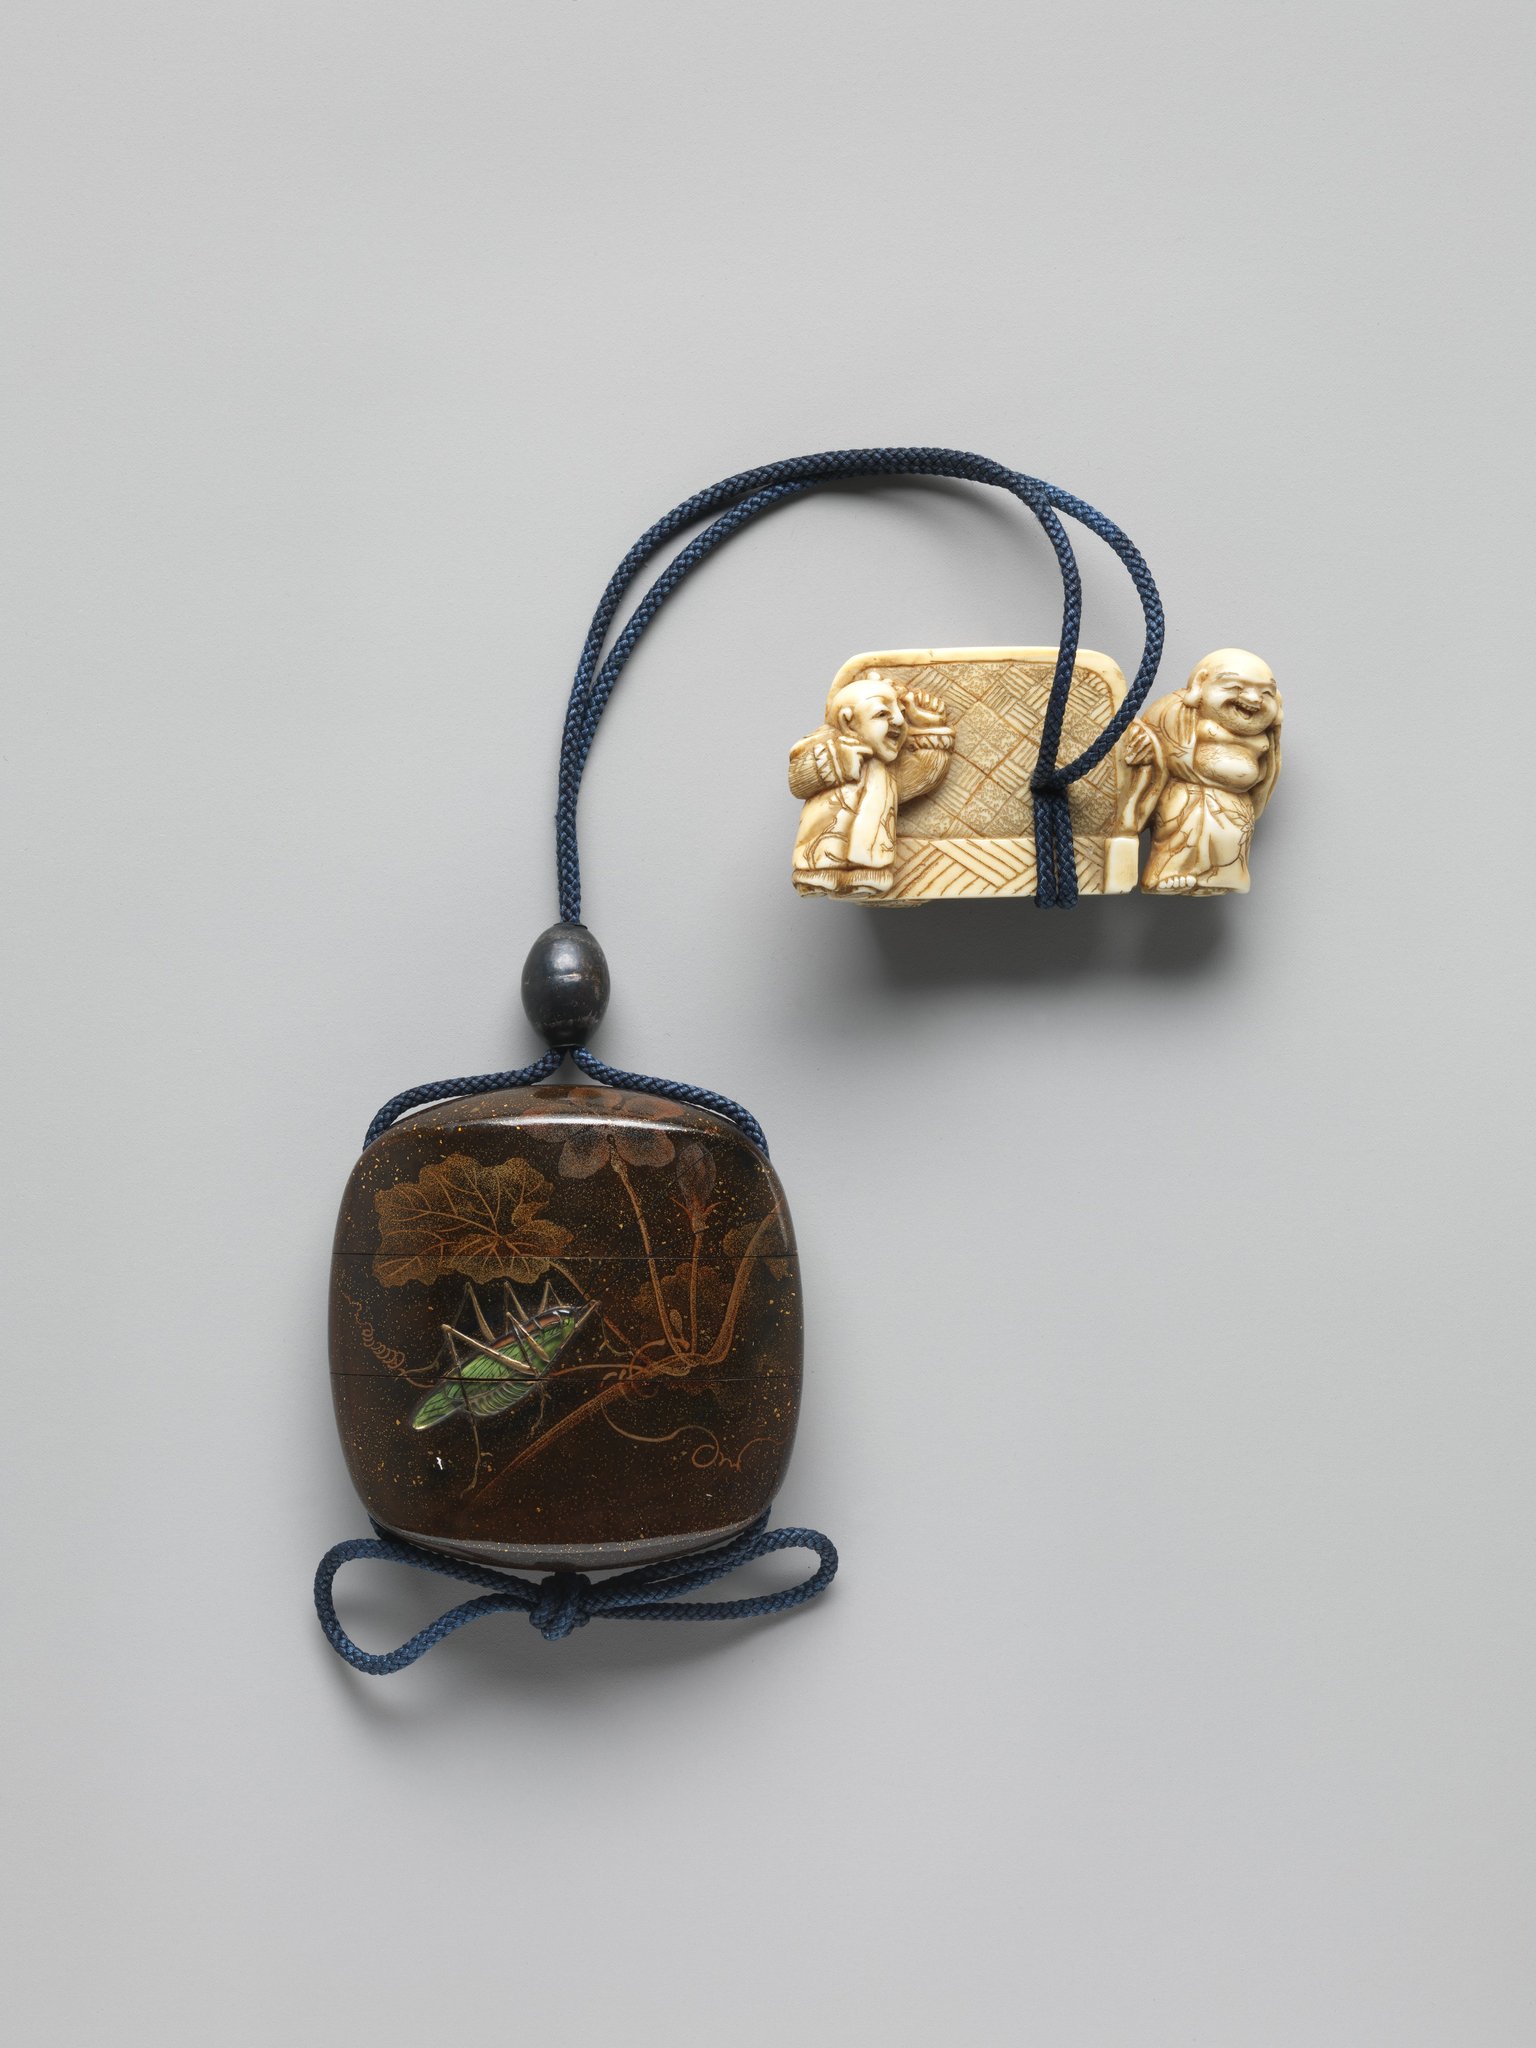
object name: inrō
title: Case (Inrō) with Design of Cricket and Muskmelon Plants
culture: japanese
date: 1867-1900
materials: gold, ivory, lacquer, metal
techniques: carving, inlay, maki, stain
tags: men,insects,plants